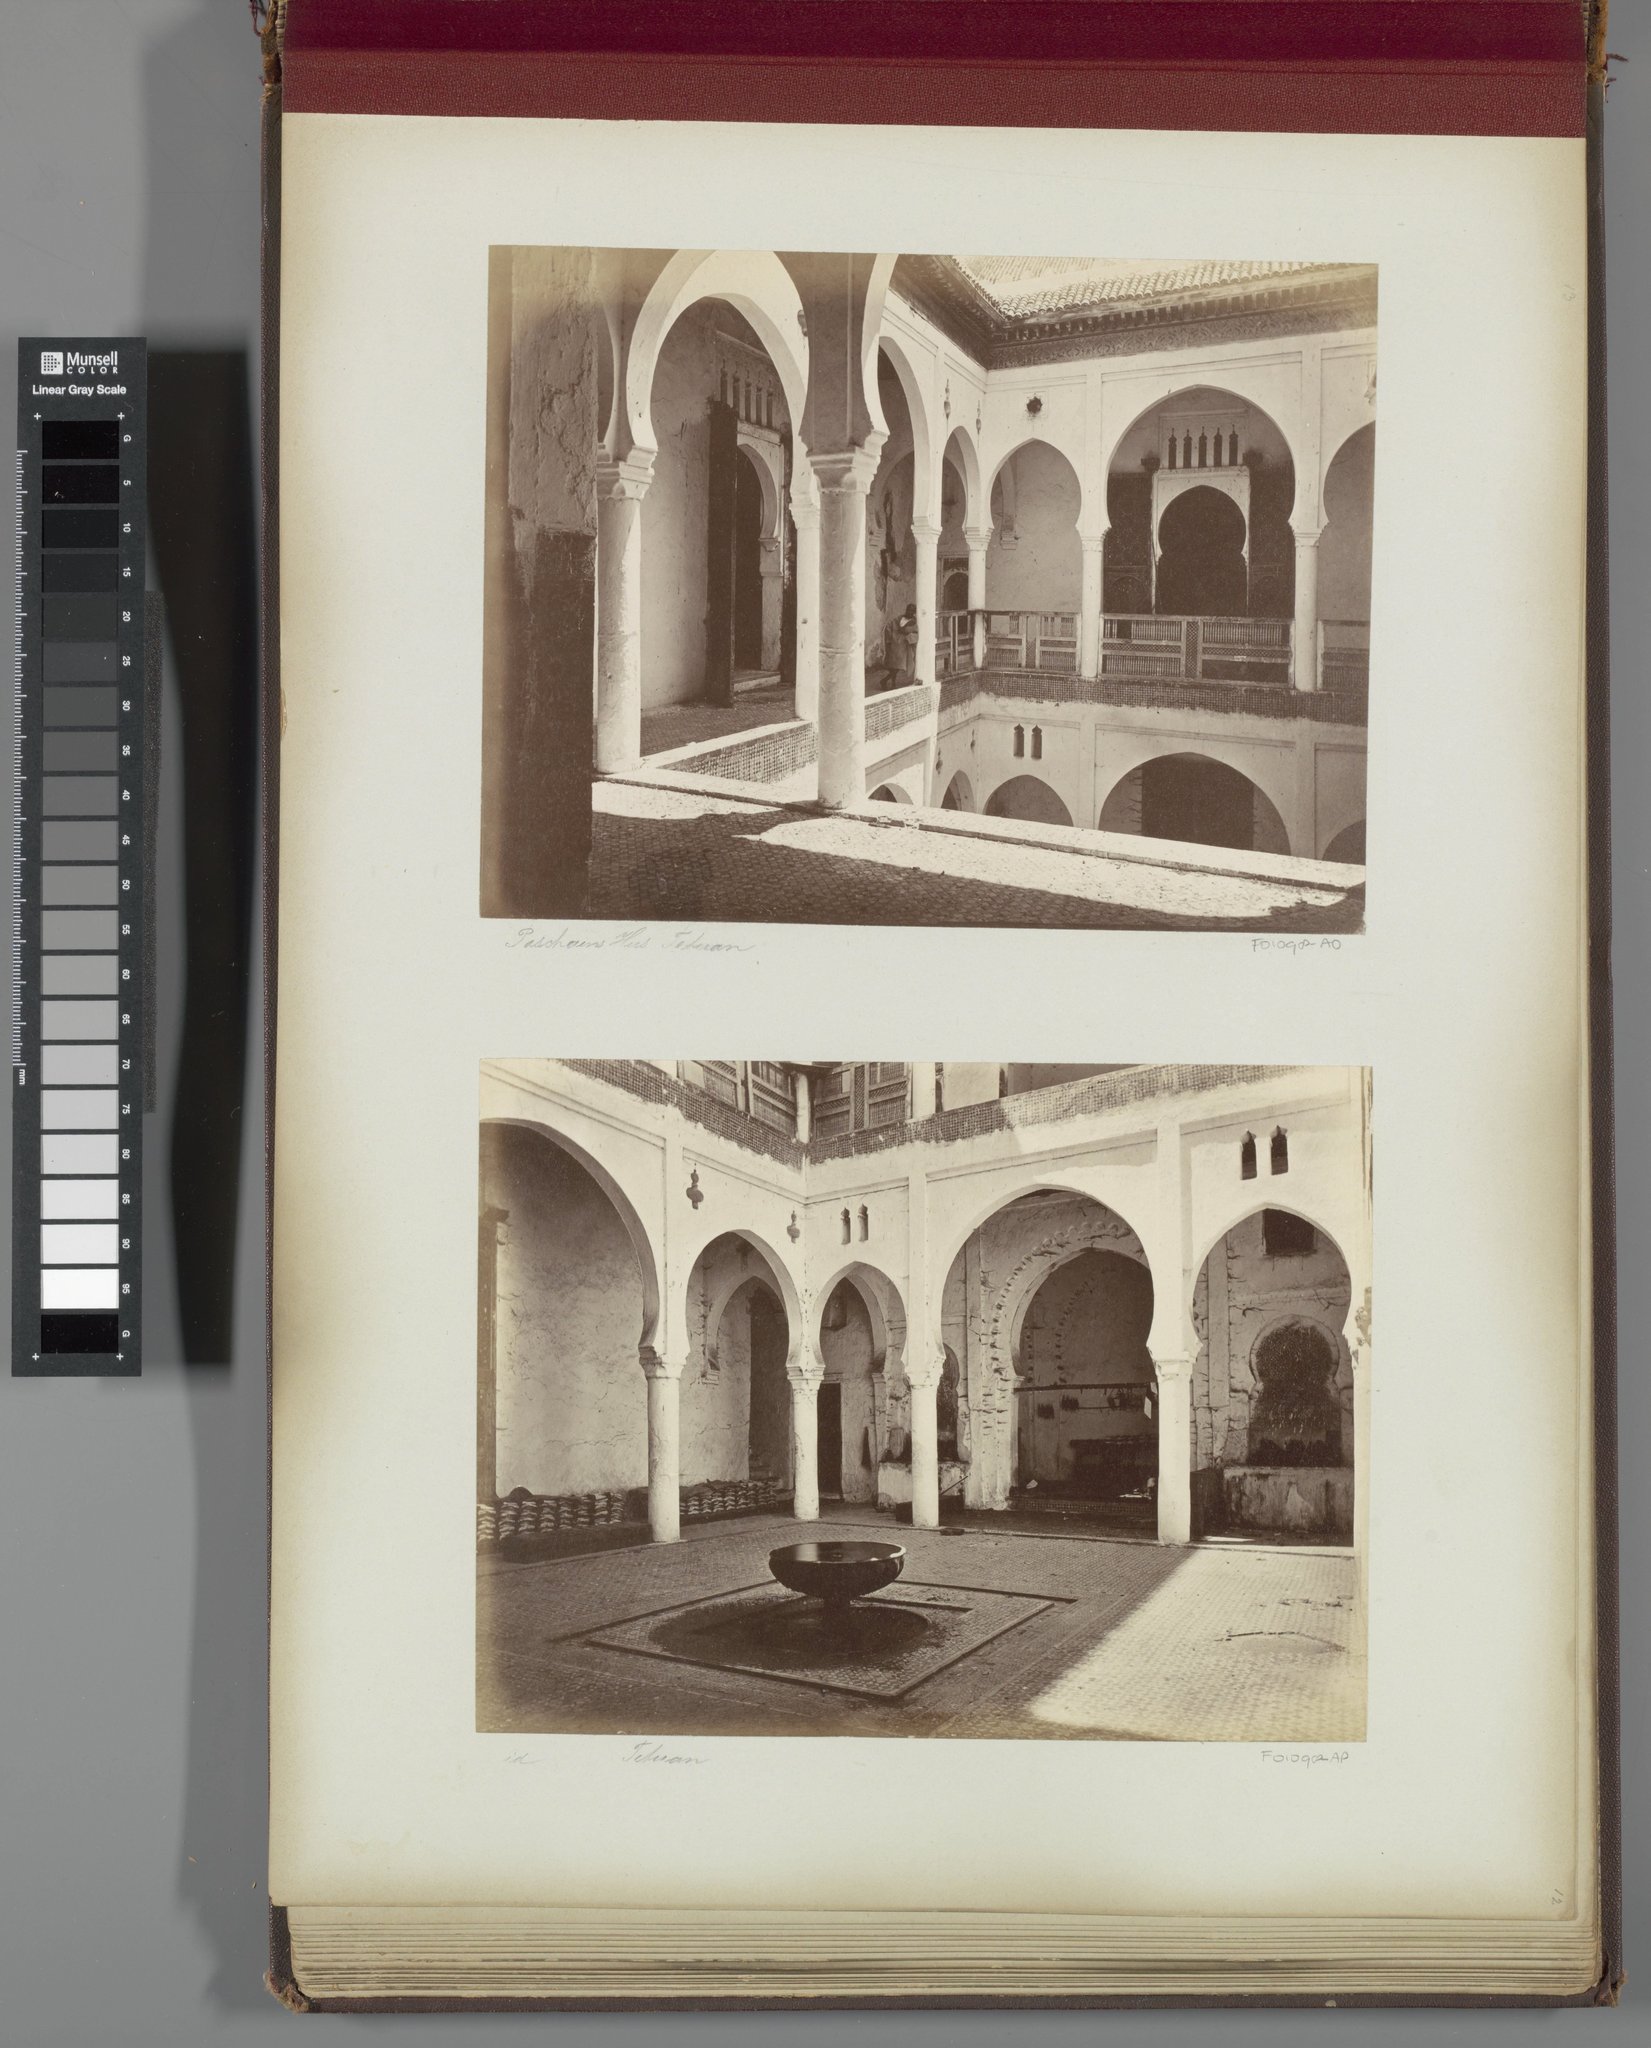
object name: photograph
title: Binnenhof met bogen van een huis in Tétouan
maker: Anonymous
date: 1860-1880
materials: cardboard, paper, photographic support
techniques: albumen print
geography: tétouan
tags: courtyard, arcade ~ architecture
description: Onderdeel van Reisalbum met foto's van bezienswaardigheden in Spanje en Marokko.